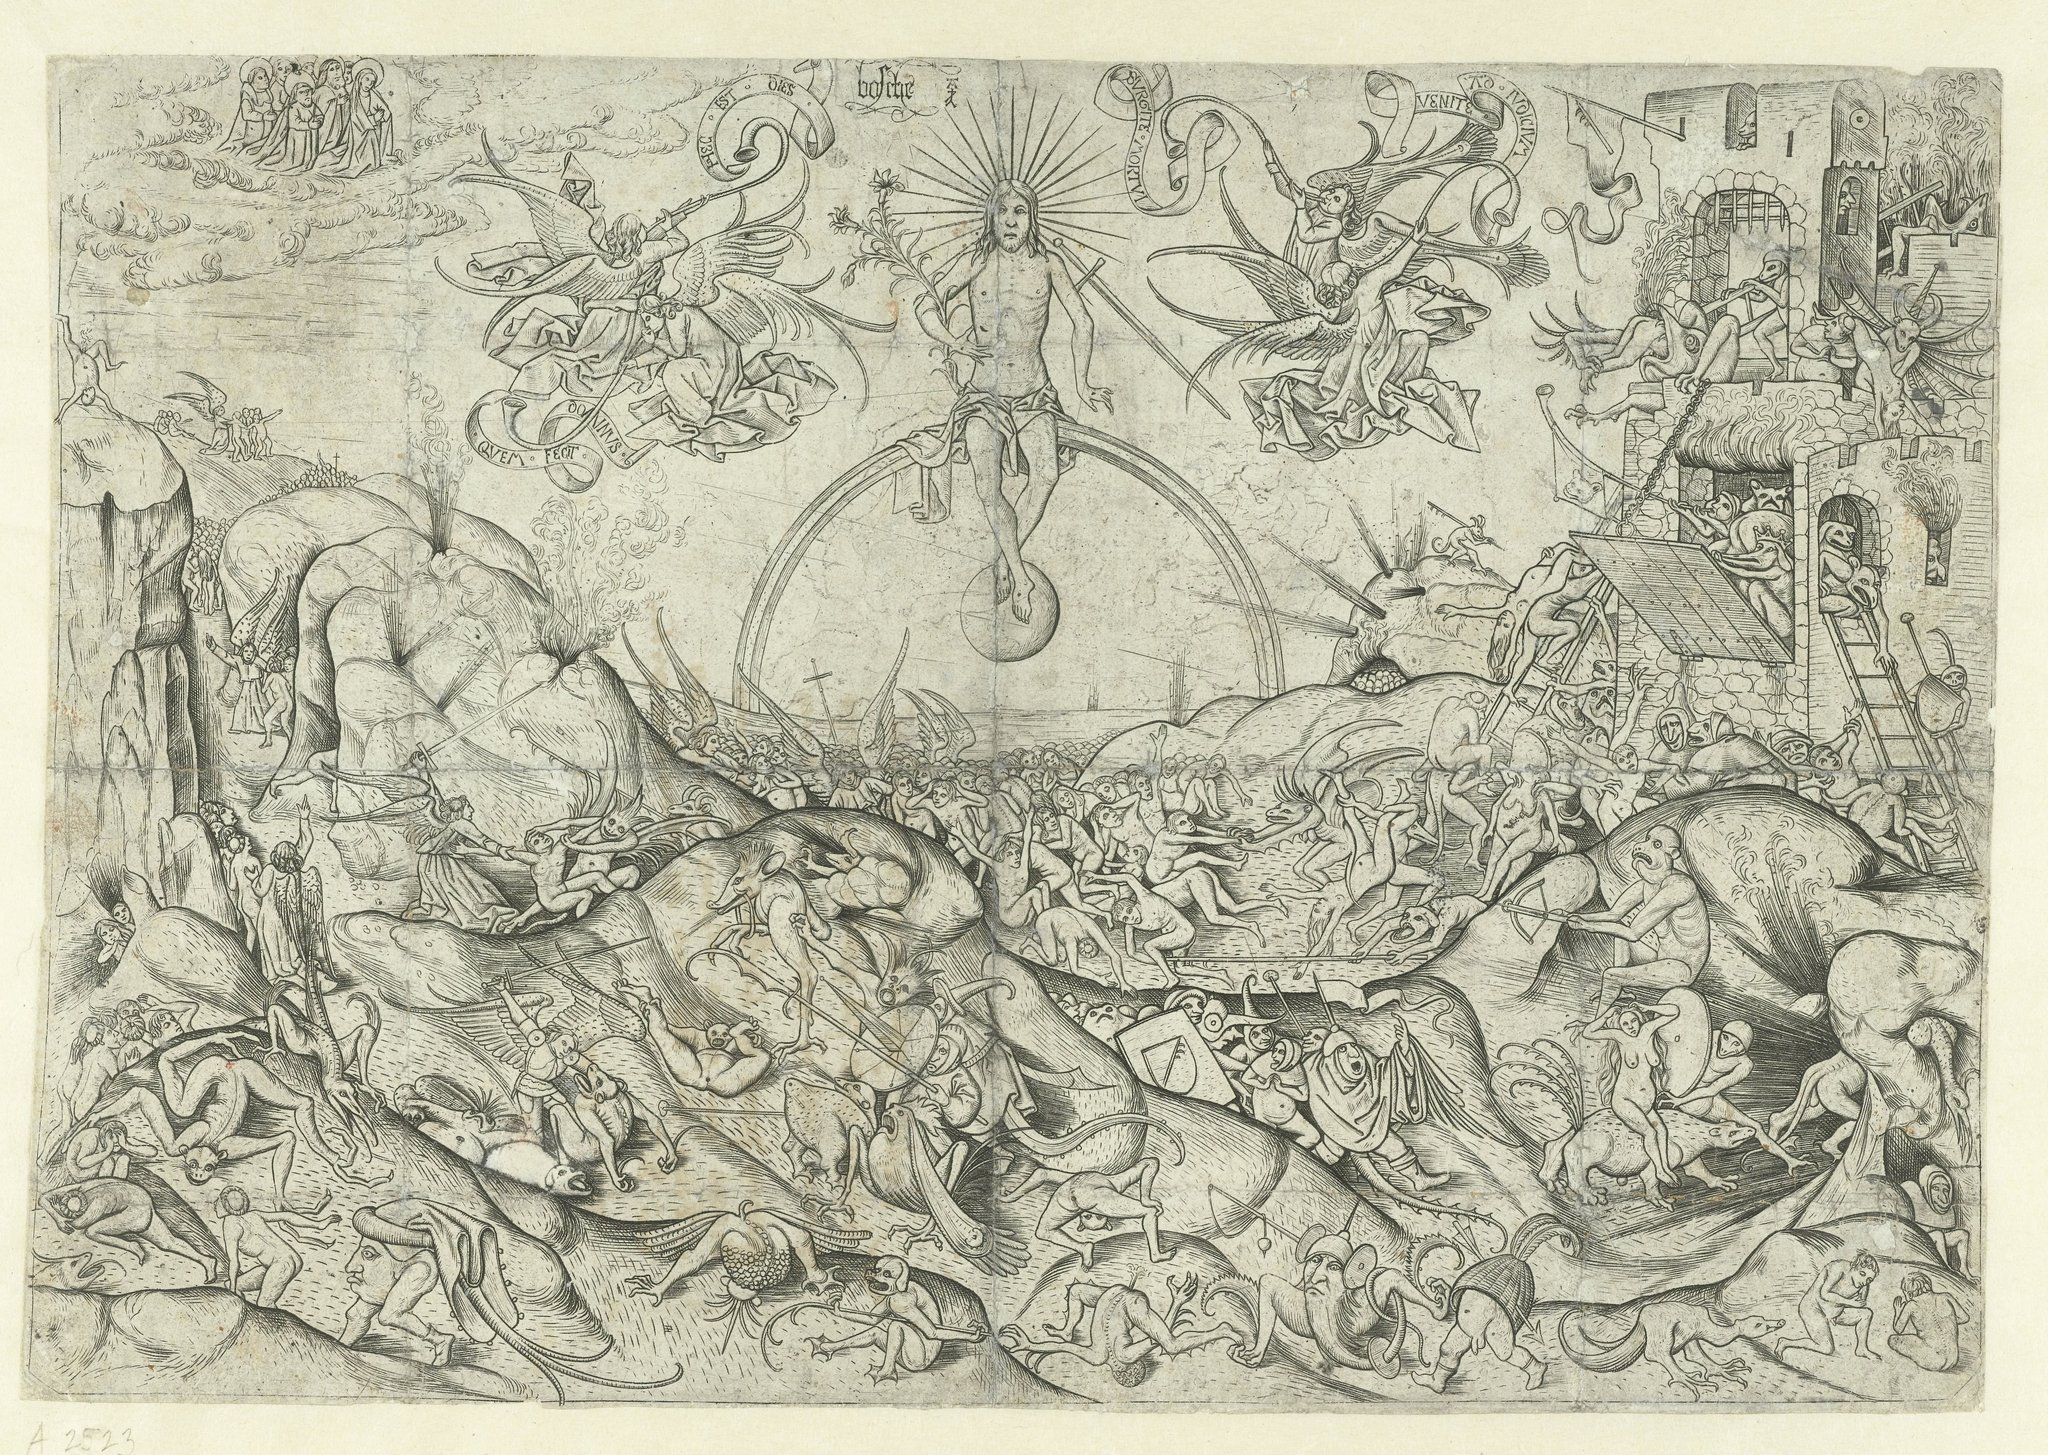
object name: print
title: Laatste Oordeel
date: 1478-1509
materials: paper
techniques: engraving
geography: low countries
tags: comprehensive representation of last judgement: christ (with sword and lily), often surrounded by elders and sometimes accompanied by mary and john the baptist, appears in the sky with trumpeting angels (and sometimes angels holding the instruments of the passion); after the resurrection of the dead the blessed are led to heaven by angels, and the damned are dragged into hell by devils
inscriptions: stamp: Lugt 2228a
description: Het laatste oordeel met Christus met zwaard en lelie op regenboog en bol. Om hem heen trompetterende engelen. Op wolk in hemel Maria en heiligen. Aan rechterhand van Christus worden mensen naar hemel geleid door engelen en aan linkerhand door duivels naar hel.